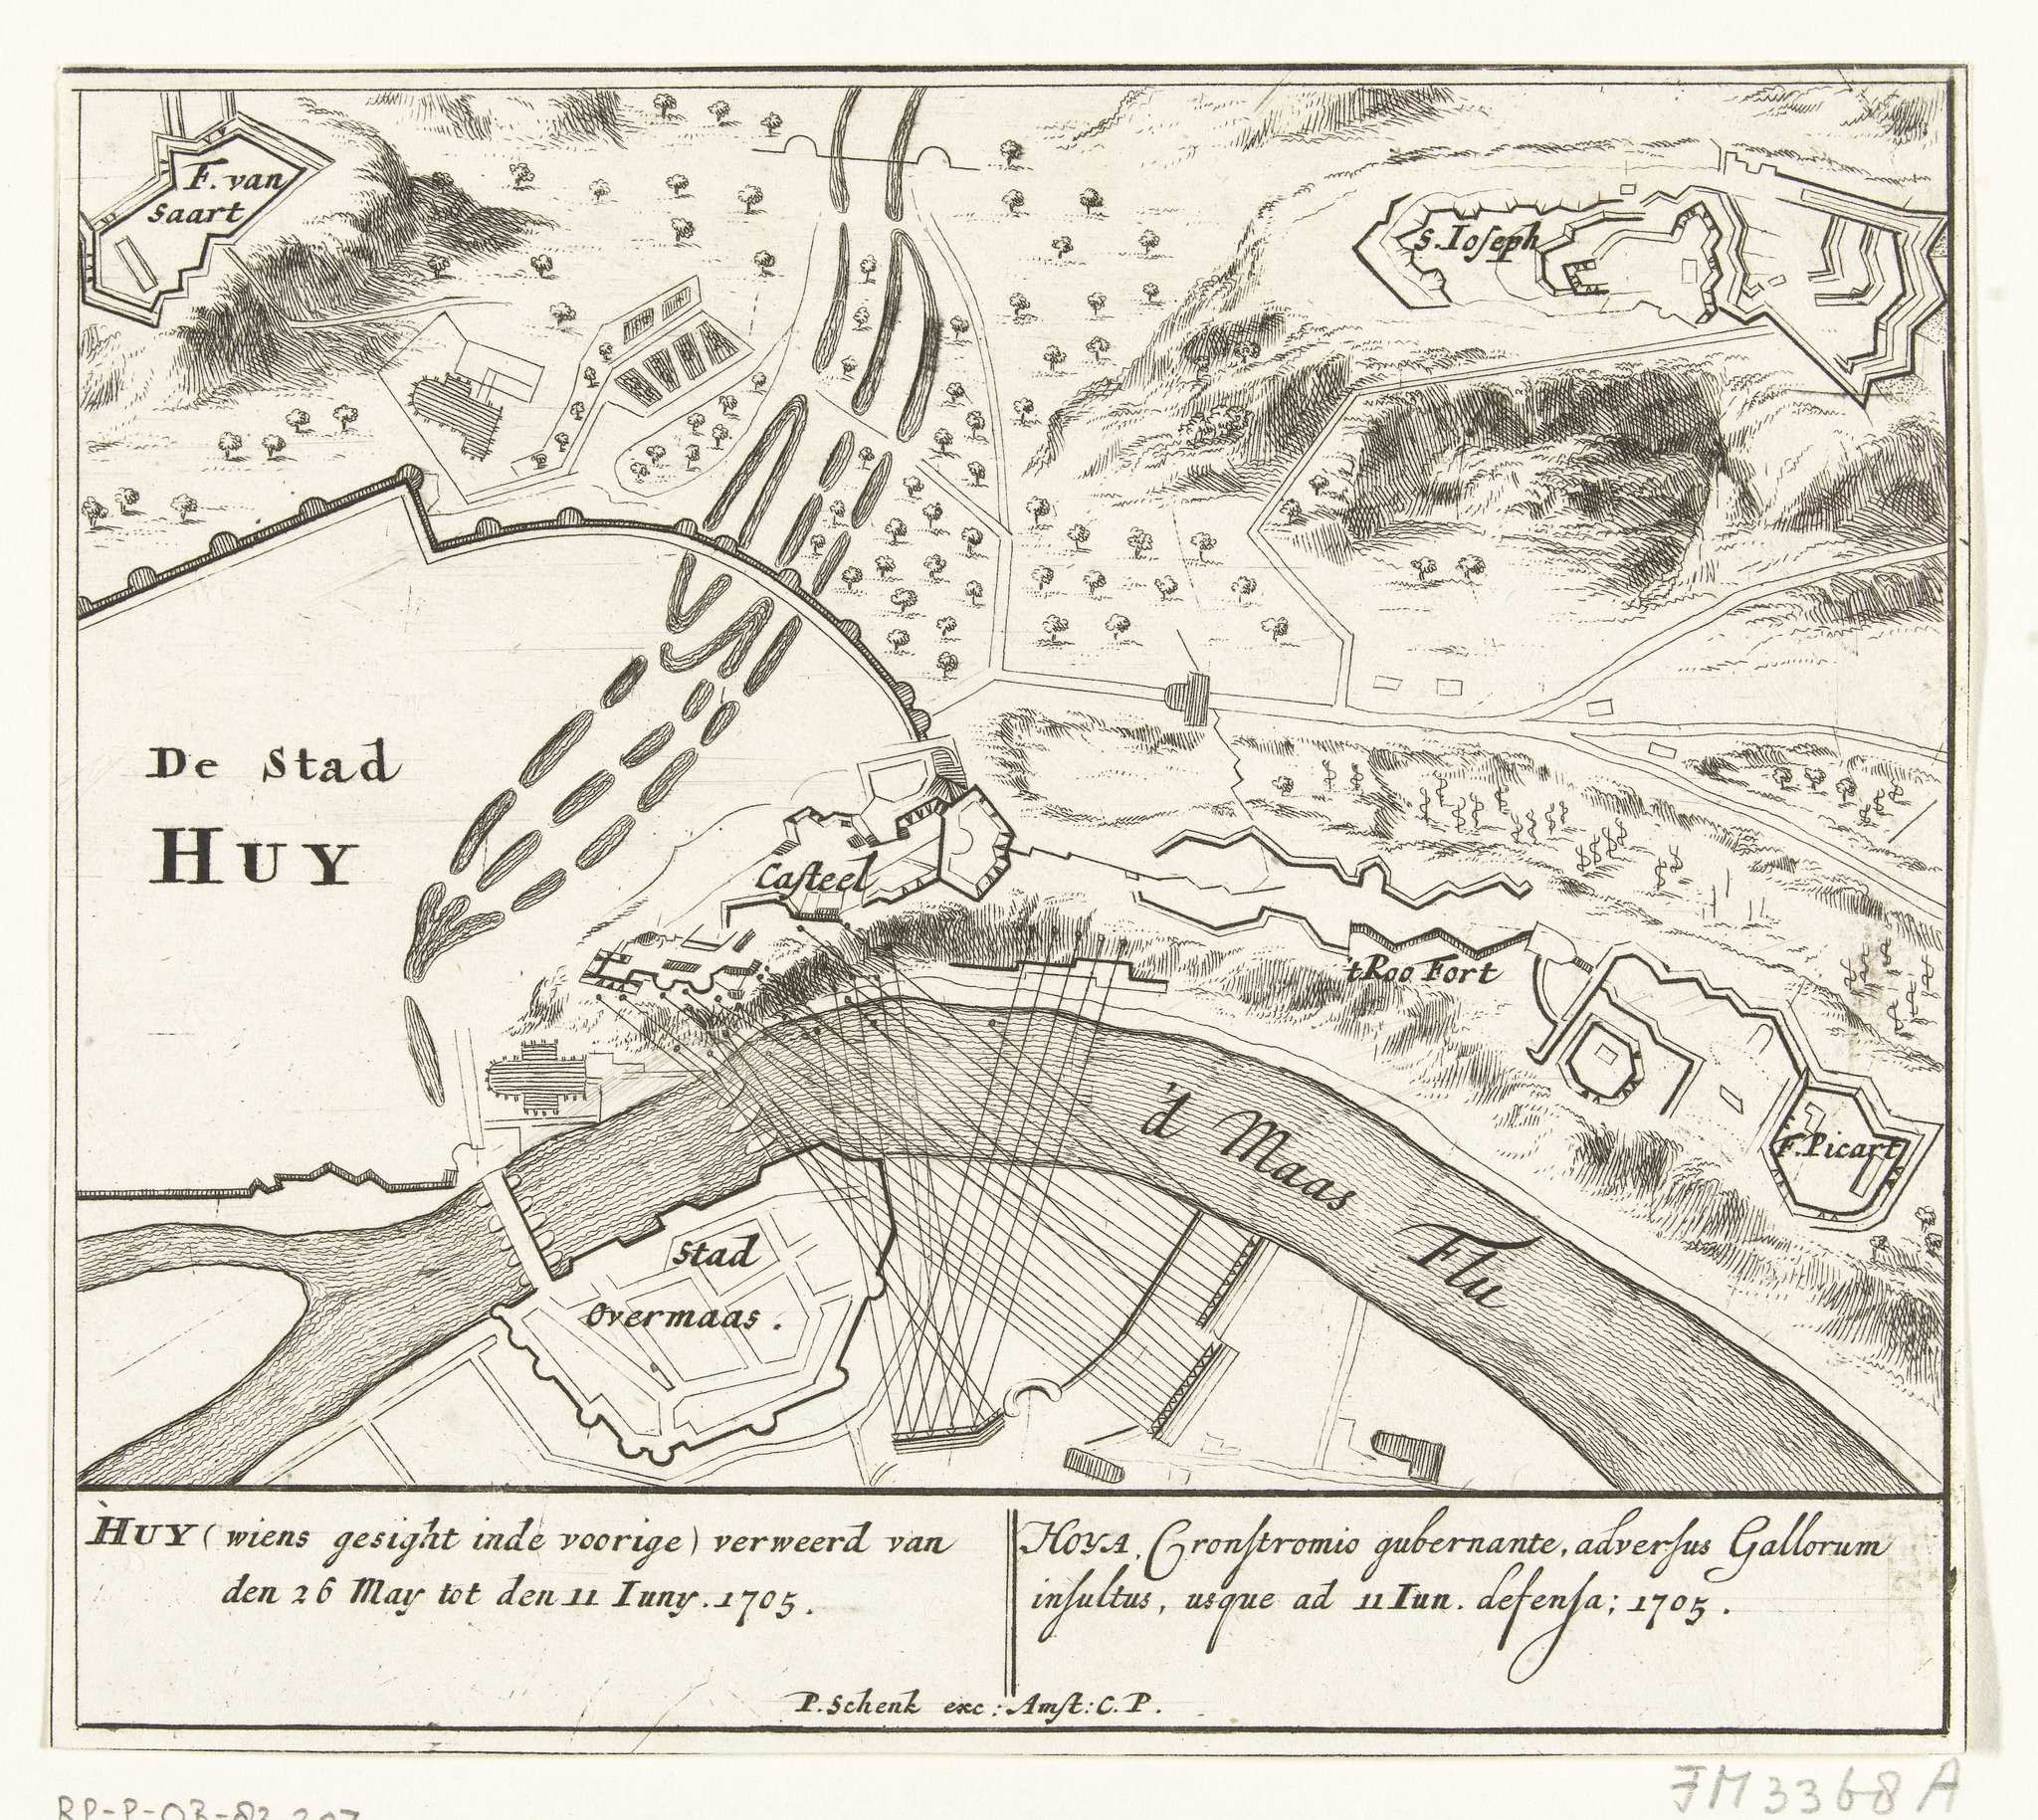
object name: print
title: Beleg van Huy, 1705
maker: pieter schenk (i)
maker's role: print maker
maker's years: 1660-1711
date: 1705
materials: paper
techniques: drypoint, etching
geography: northern netherlands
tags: siege, position war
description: Kaartje van het beleg en inname van Huy door de Geallieerden, van 26 mei tot 11 Juni 1705. Ook uitgegeven als een van de negen voorstellingen op een groot blad met gebeurtenissen uit het jaar 1705 van de Spaanse Successieoorlog.